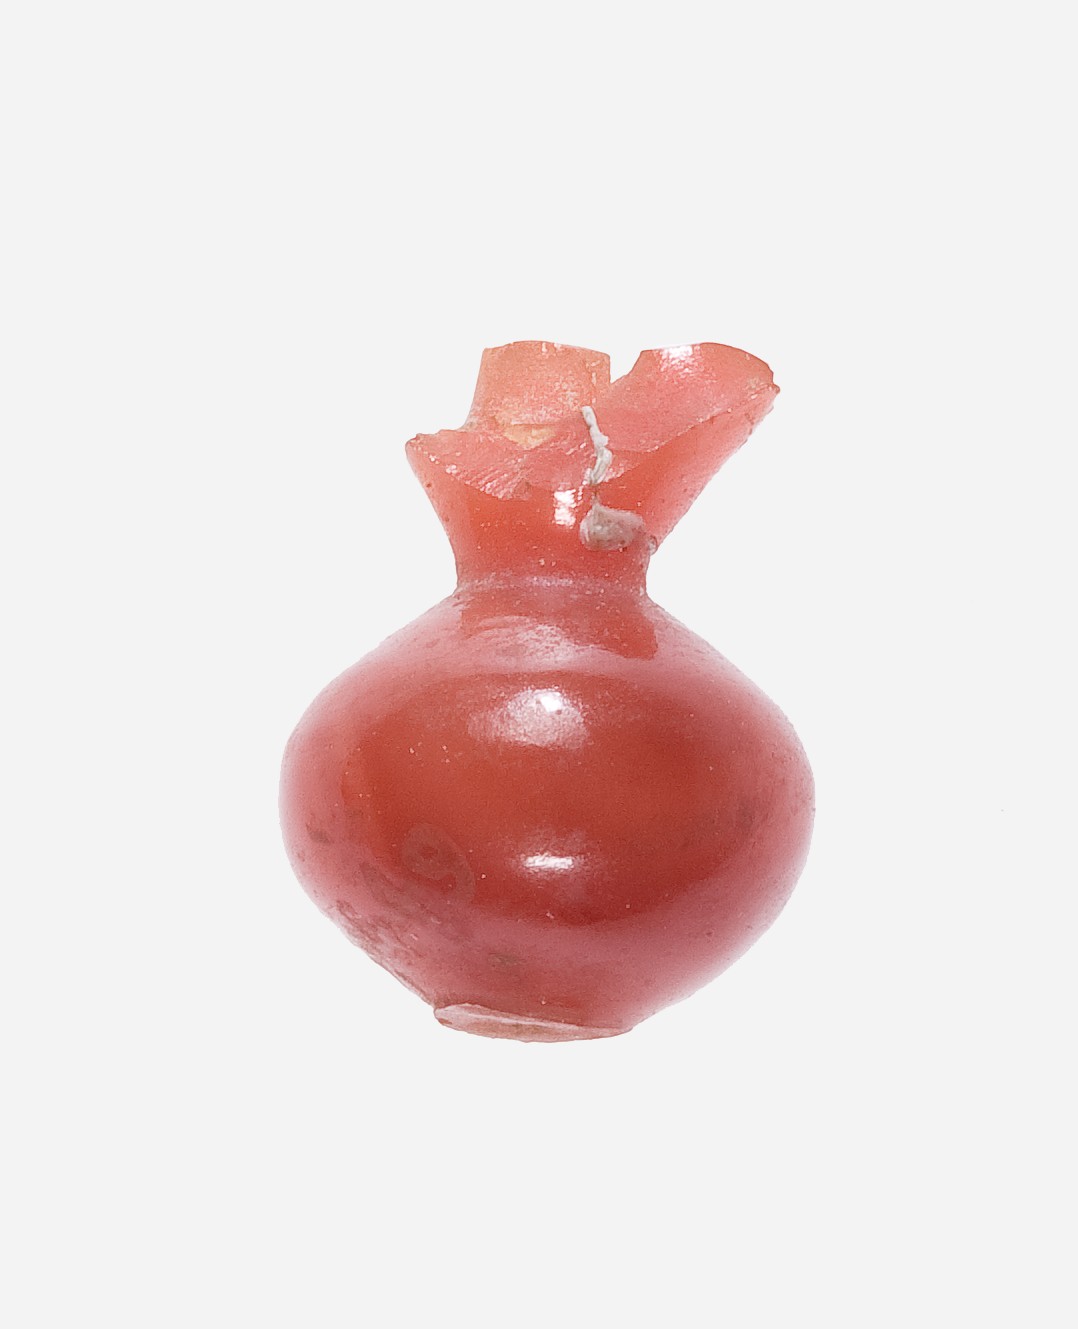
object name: pendant, pomegranate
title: Pomegranate Pendant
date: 1390-1352 BCE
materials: gemstone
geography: egypt